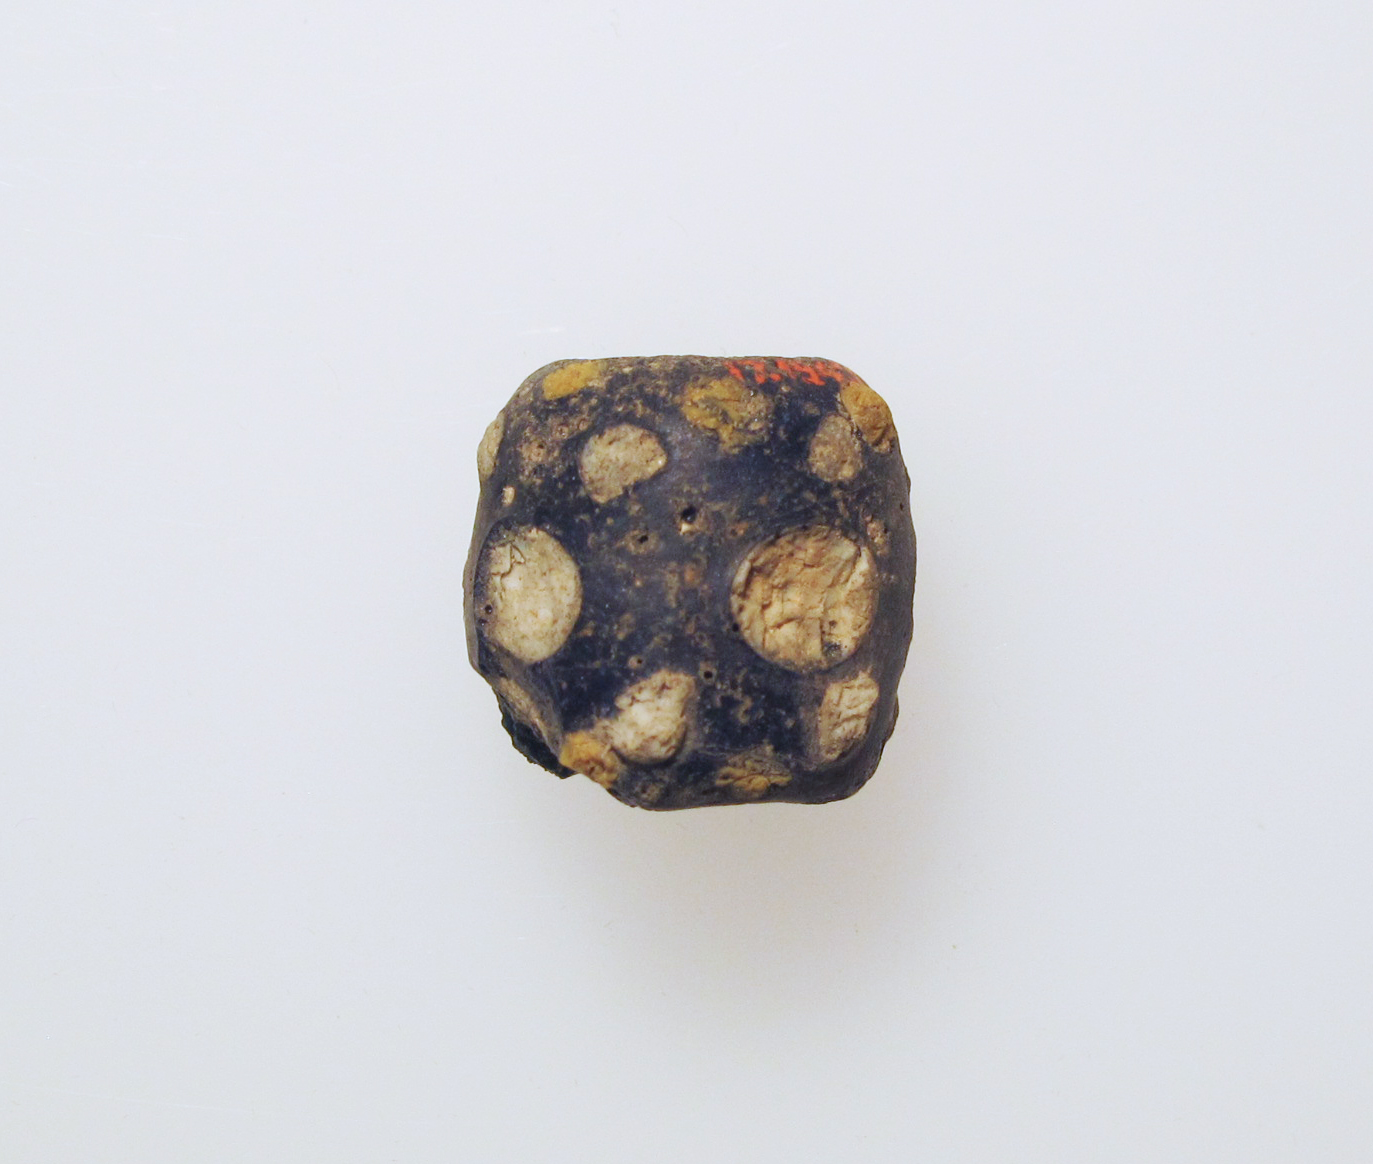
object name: bead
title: Glass eye bead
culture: carthaginian or phoenician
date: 400-201 BCE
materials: glass